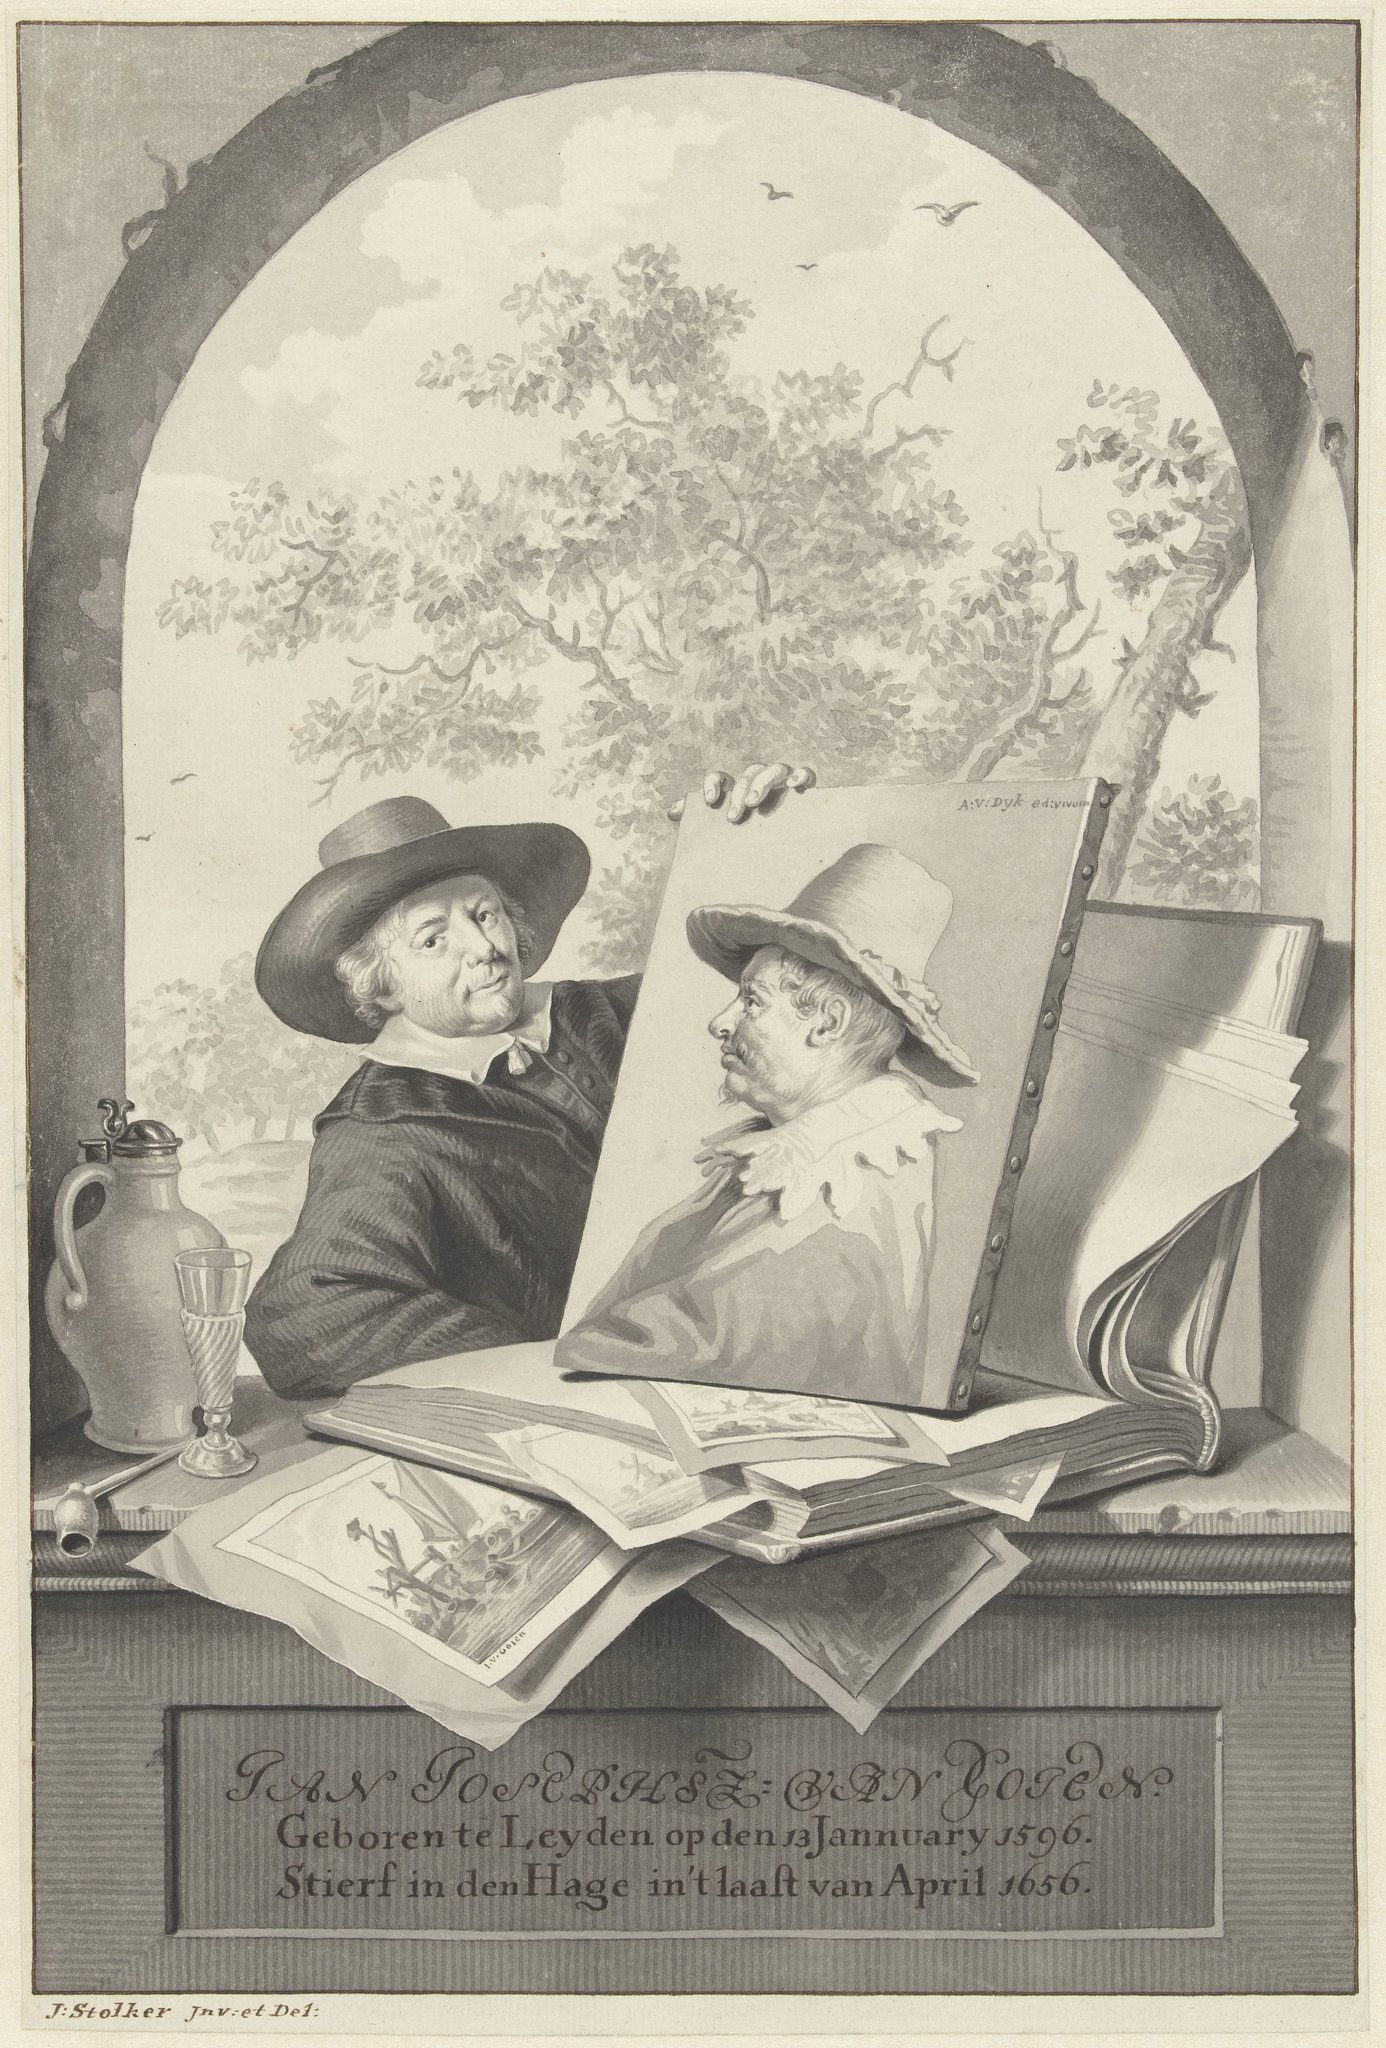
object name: drawing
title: Man met een map met tekeningen en een portret van Jan van Goyen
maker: jan stolker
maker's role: draughtsman, painter, print maker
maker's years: 1724-1785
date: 1734-1785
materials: ink, paper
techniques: brush, pen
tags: leiden, the hague, painter, draughtsman, jan van goyen, historical persons, portrait, self-portrait of painter, picture within picture, portrait, self-portrait of artist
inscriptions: inscription: ‘Jan Josephsz: van Goien. / Geboren te Leyden op den 13 Jannuary 1596. / Stierf in den Hage in 't laatst van April 1656.’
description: Man in een venster met een grote map met tekeningen en het portret van Jan van Goyen door A. van Dyck.